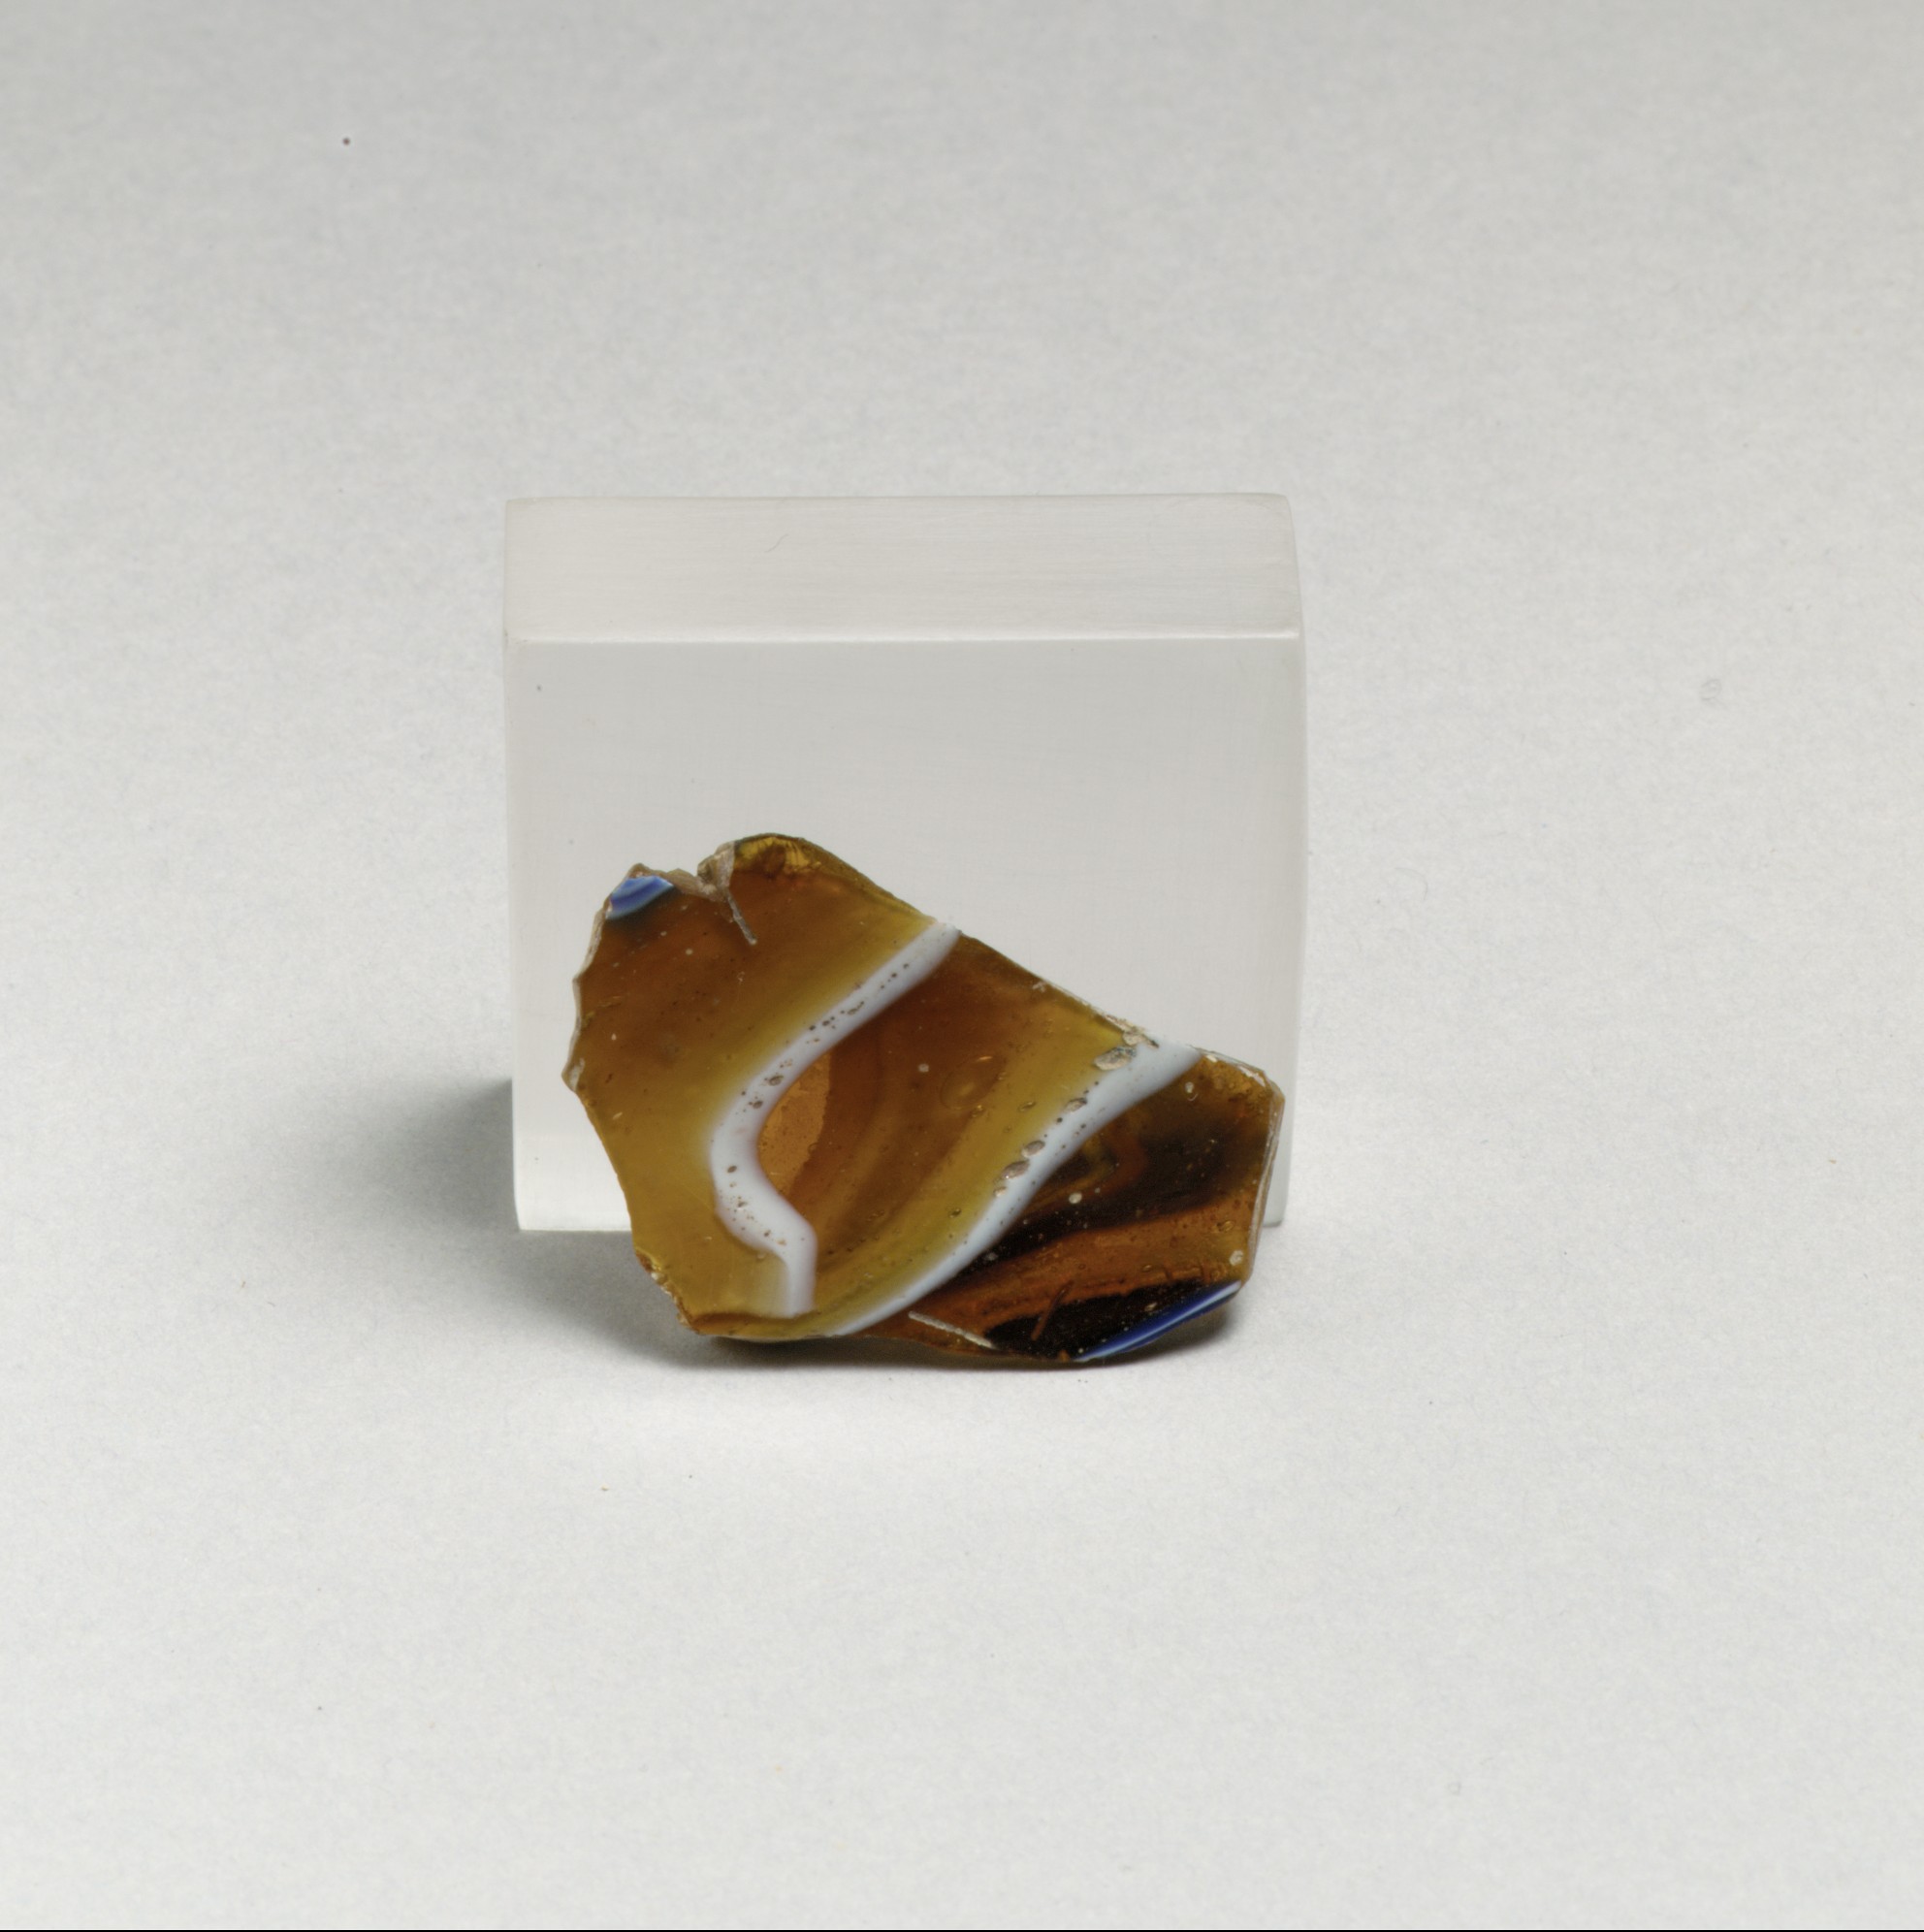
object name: fragment, ribbed bowl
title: Glass mosaic ribbed bowl fragment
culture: roman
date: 34 BCE-33 CE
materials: glass